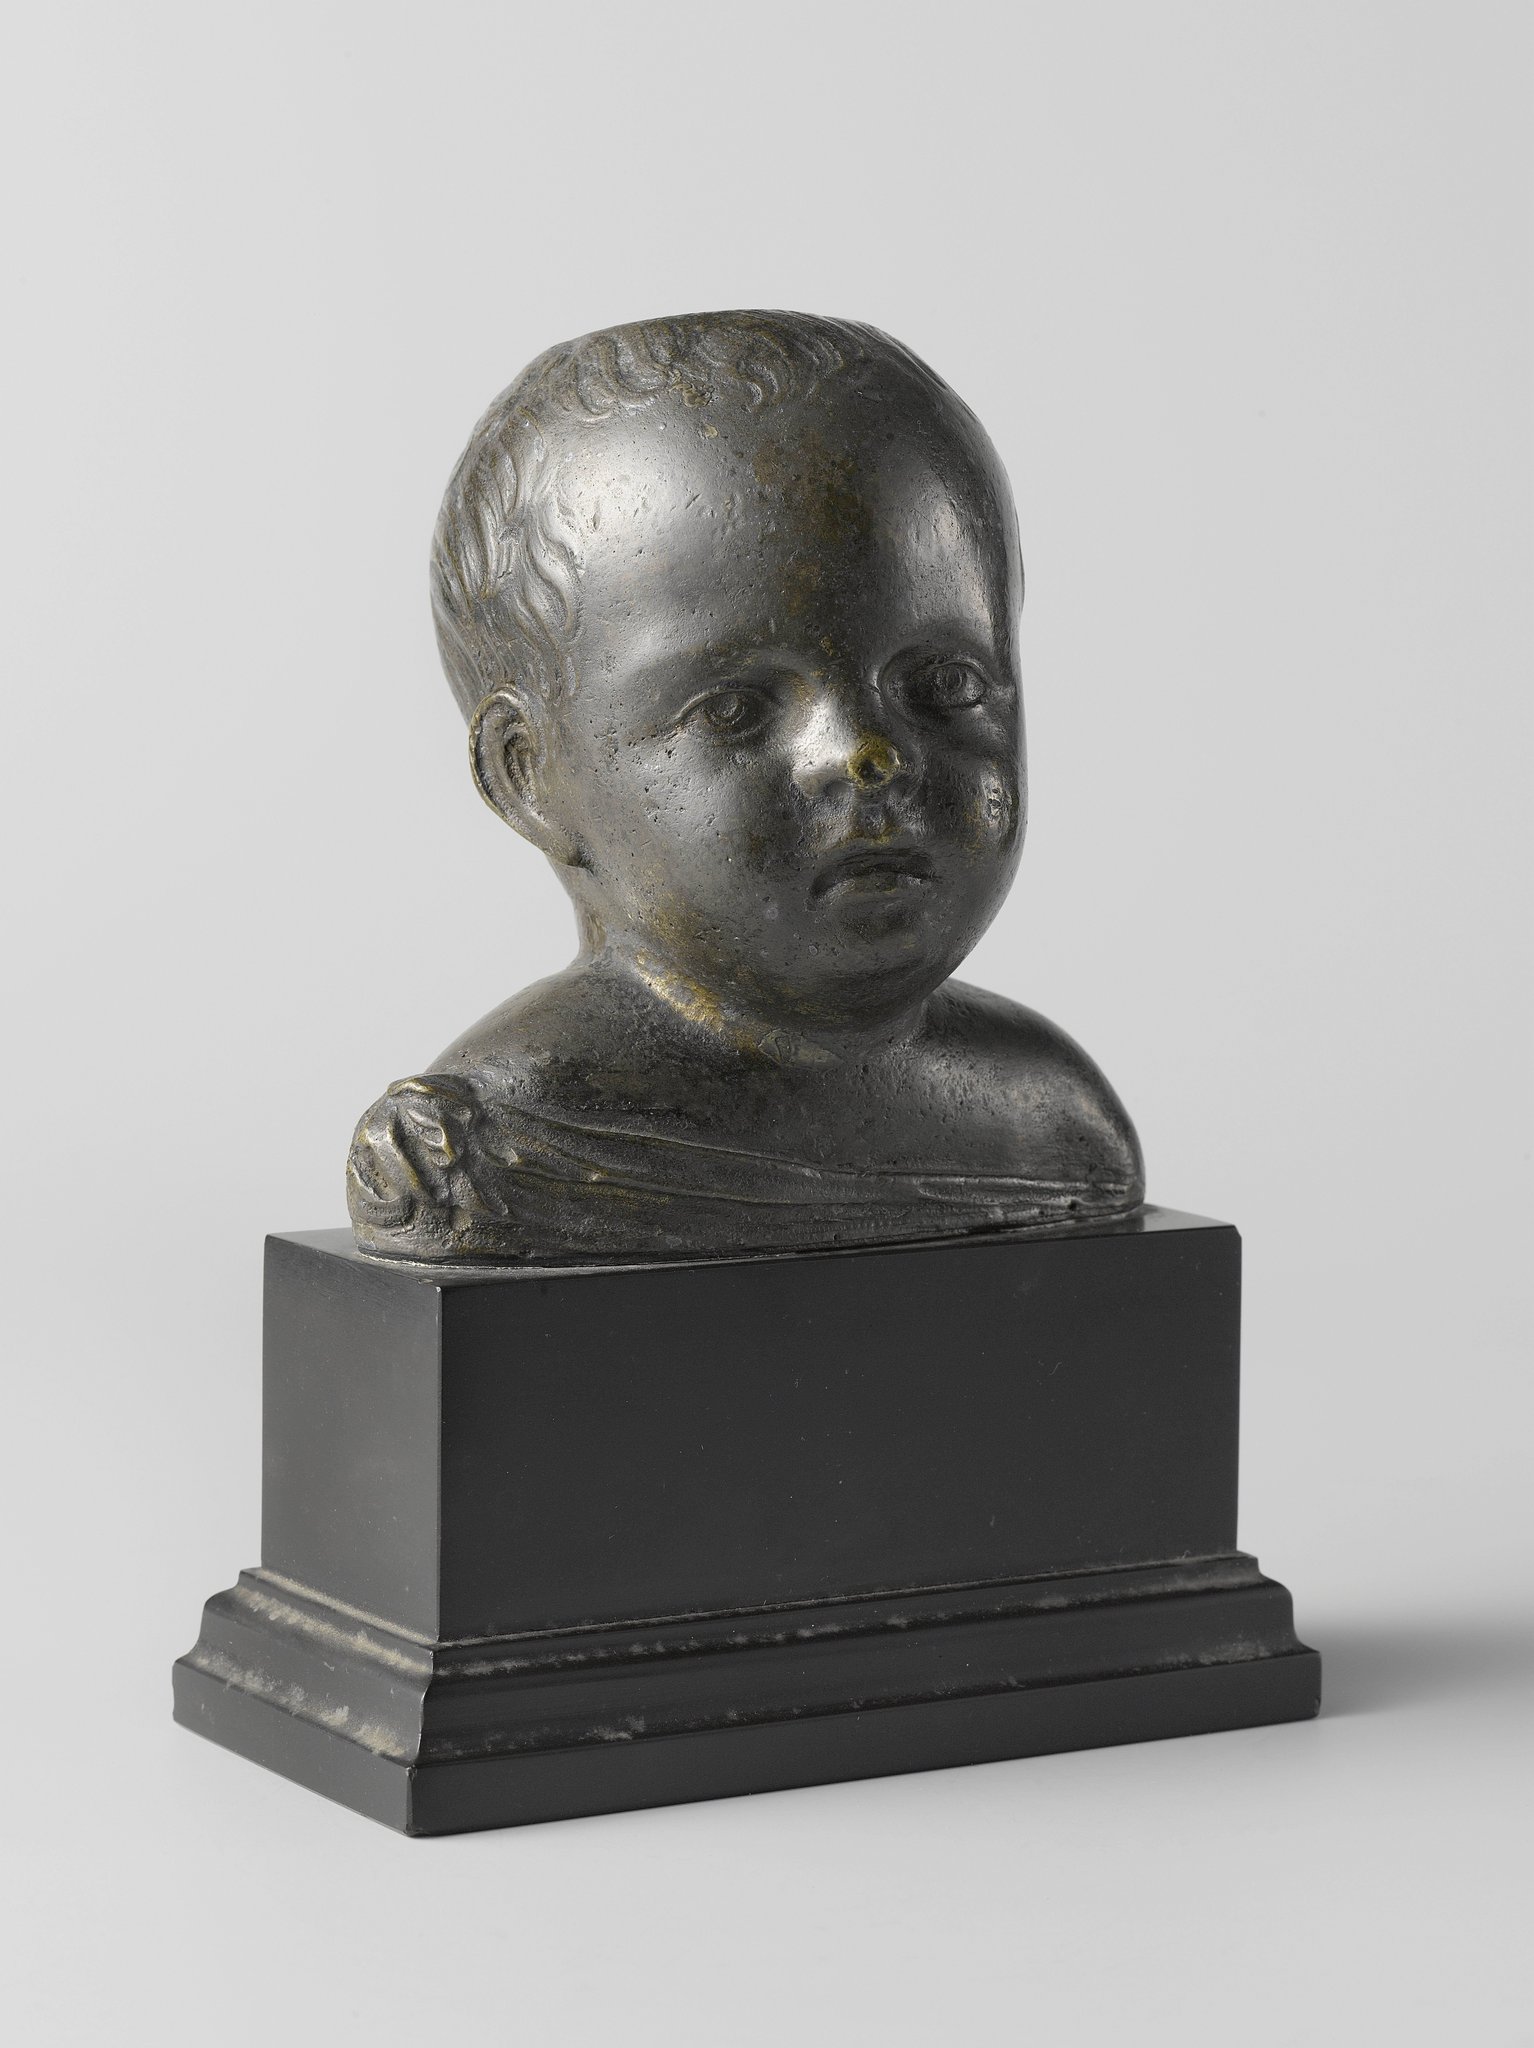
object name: sculpture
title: Borstbeeld van een kind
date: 1500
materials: bronze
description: Bust of a child. Bronze. Florence or Padua, c. 1500.